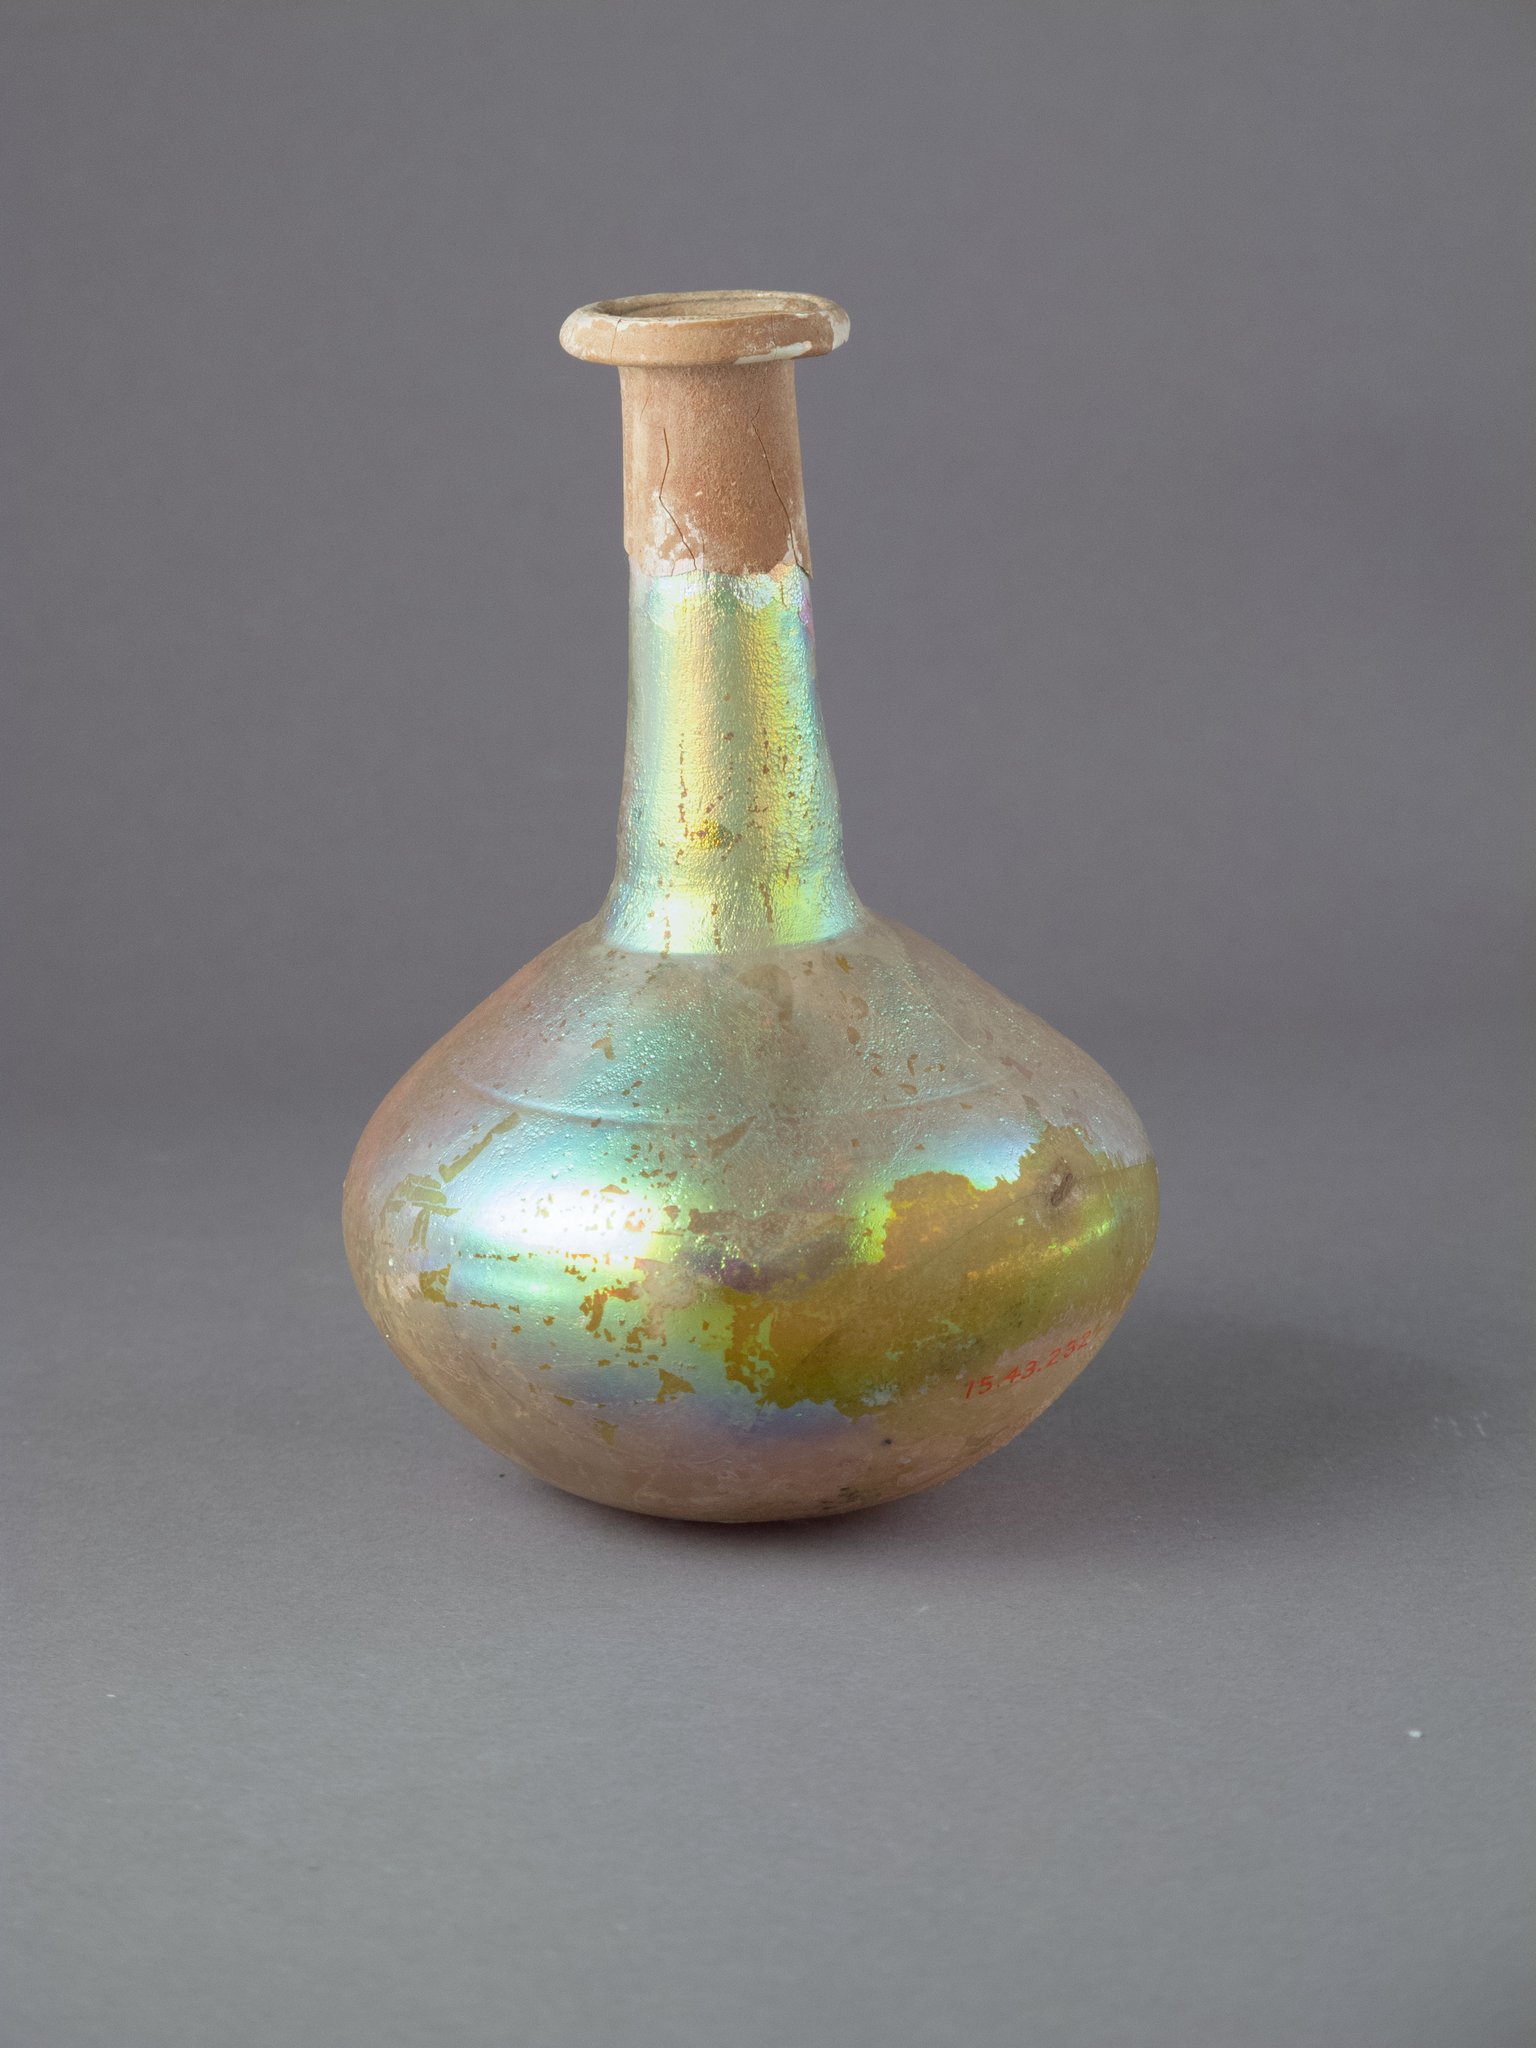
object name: perfume bottle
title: Glass perfume bottle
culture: roman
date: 1-100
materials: glass